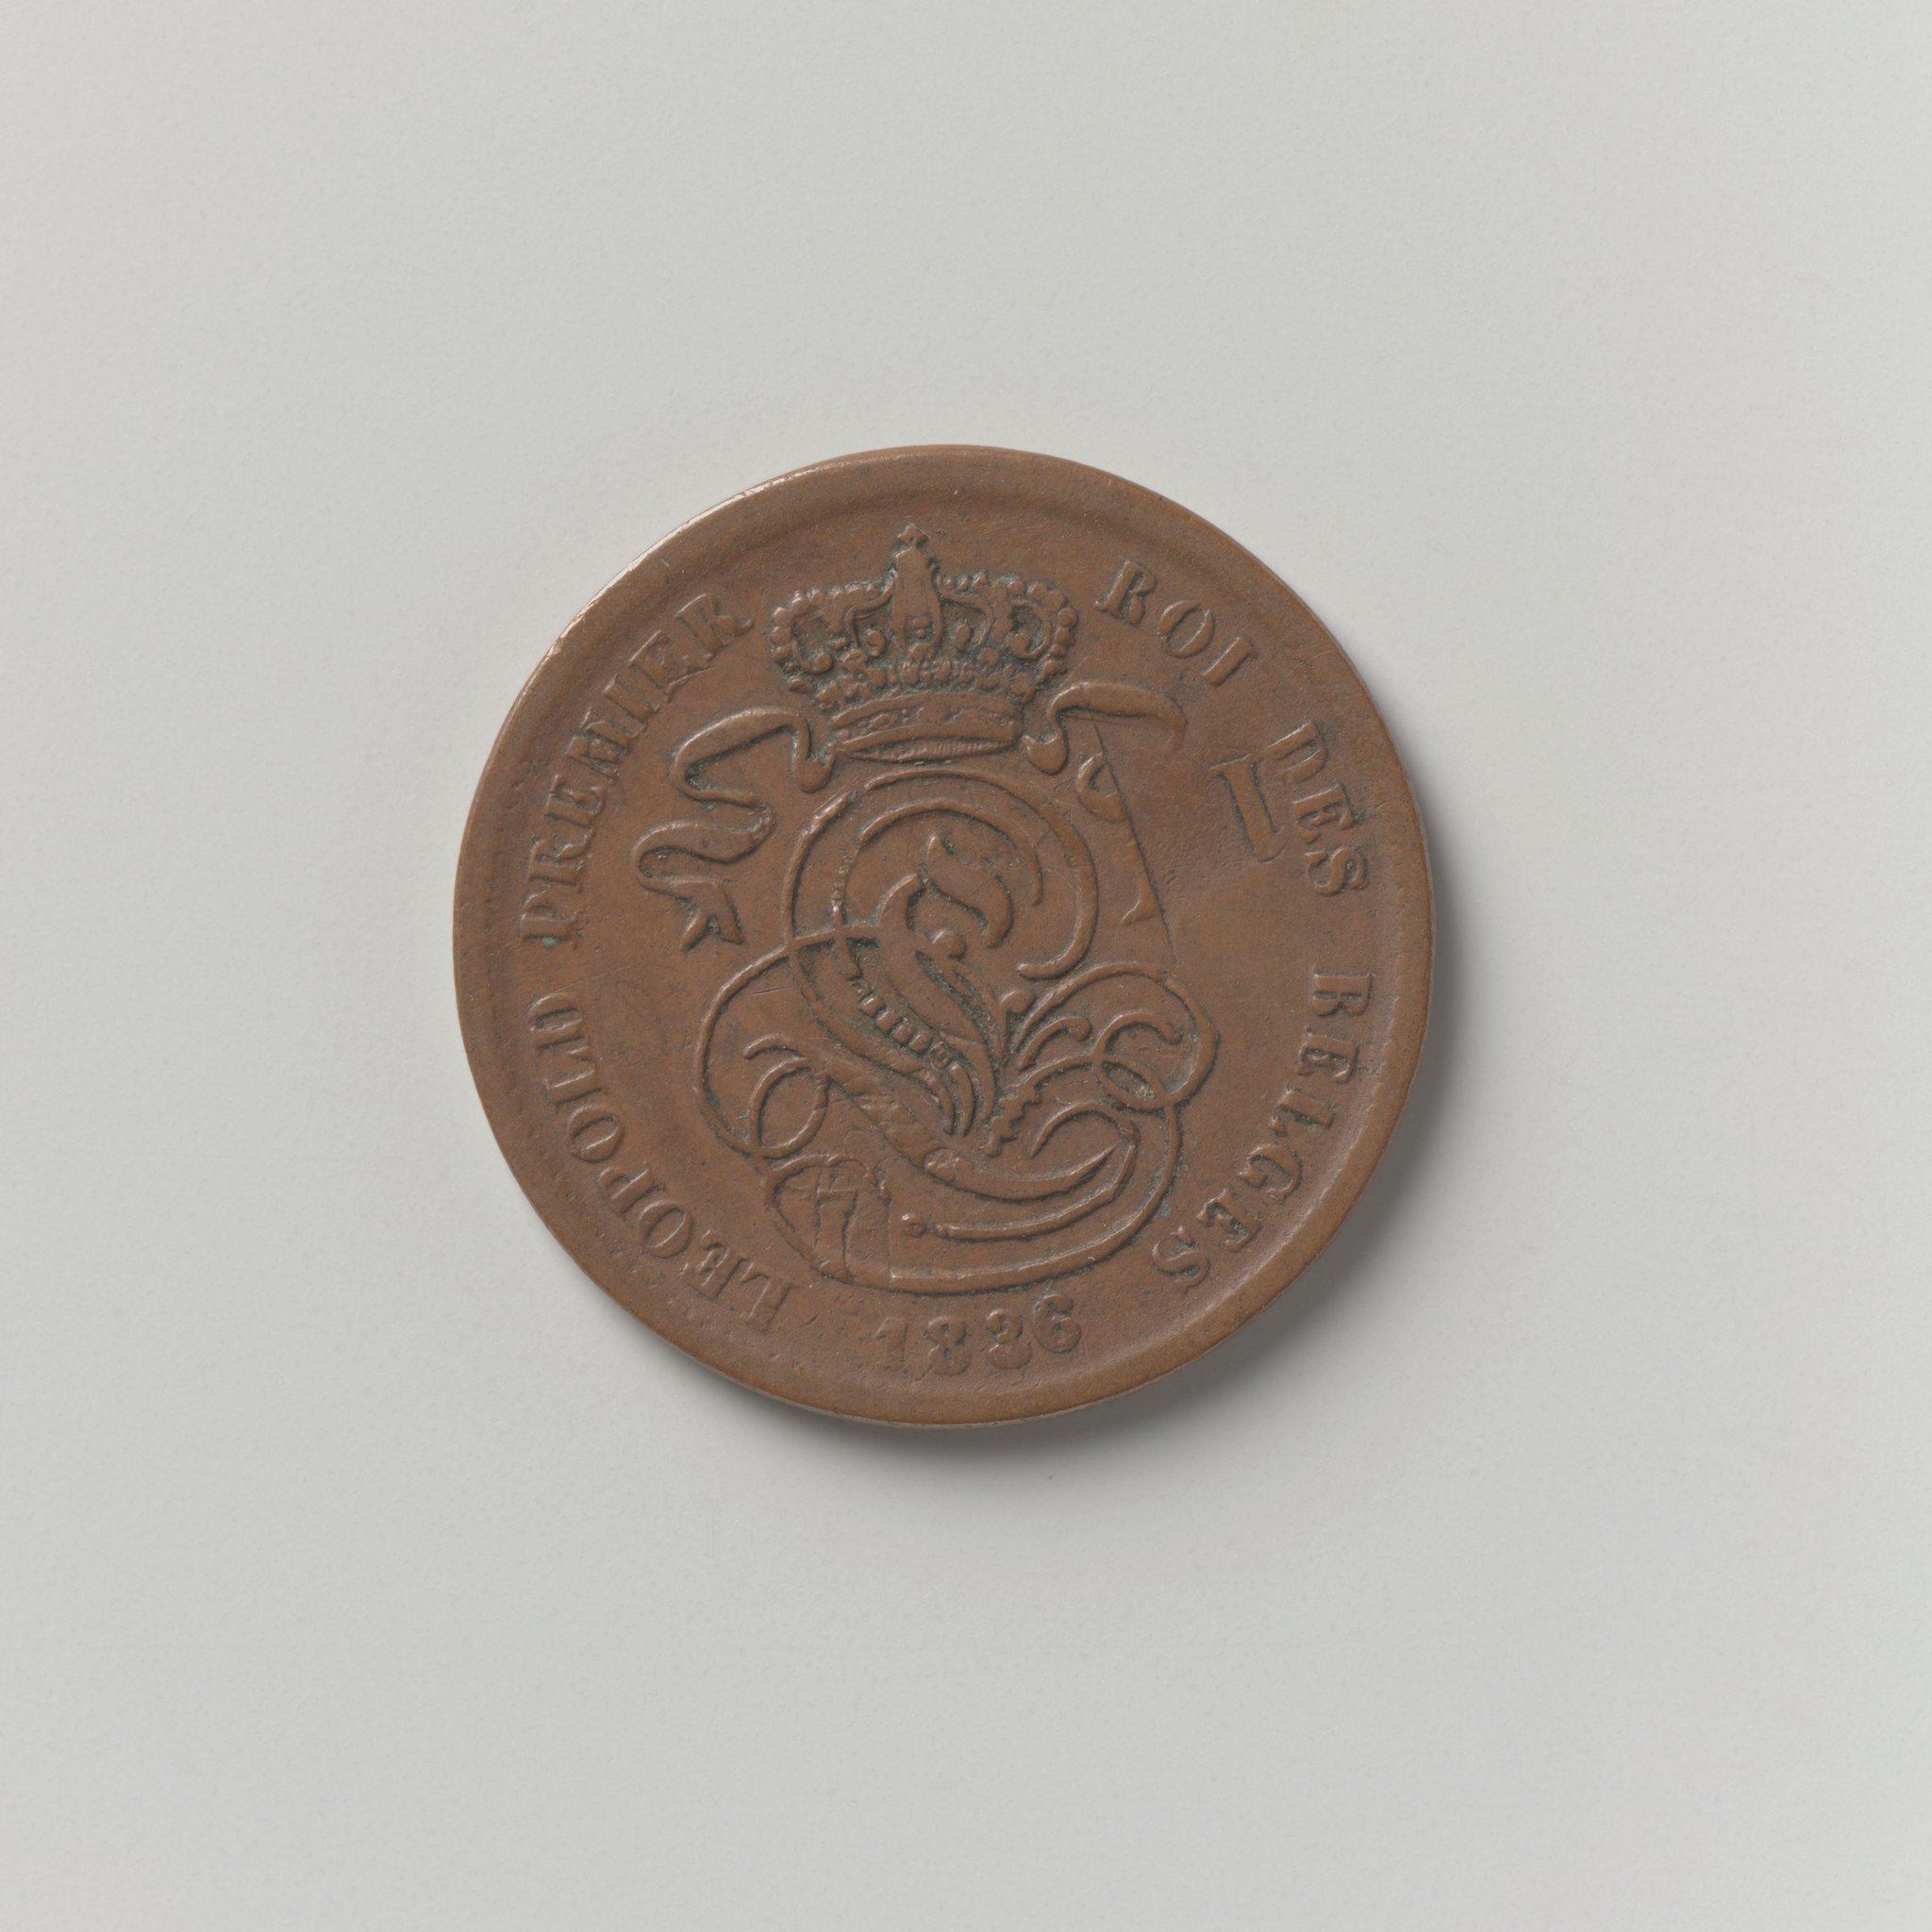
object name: twee centime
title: België, Leopold I, 2 centimes, 1836, op muntplaatje van Nederlandse cent.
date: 1836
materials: copper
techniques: striking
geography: brussels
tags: leopold i (koning der belgen)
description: Koperen munt. Voorzijde: zittende, omkijkende leeuw naar links met onder rechter klauw paneel met opschrift. In afsnede waarde-aanduiding. Keerzijde: gekroond monogram. Jaartal onderaan. Kartelrandf.Op muntplaatje van Nederlandse cent.